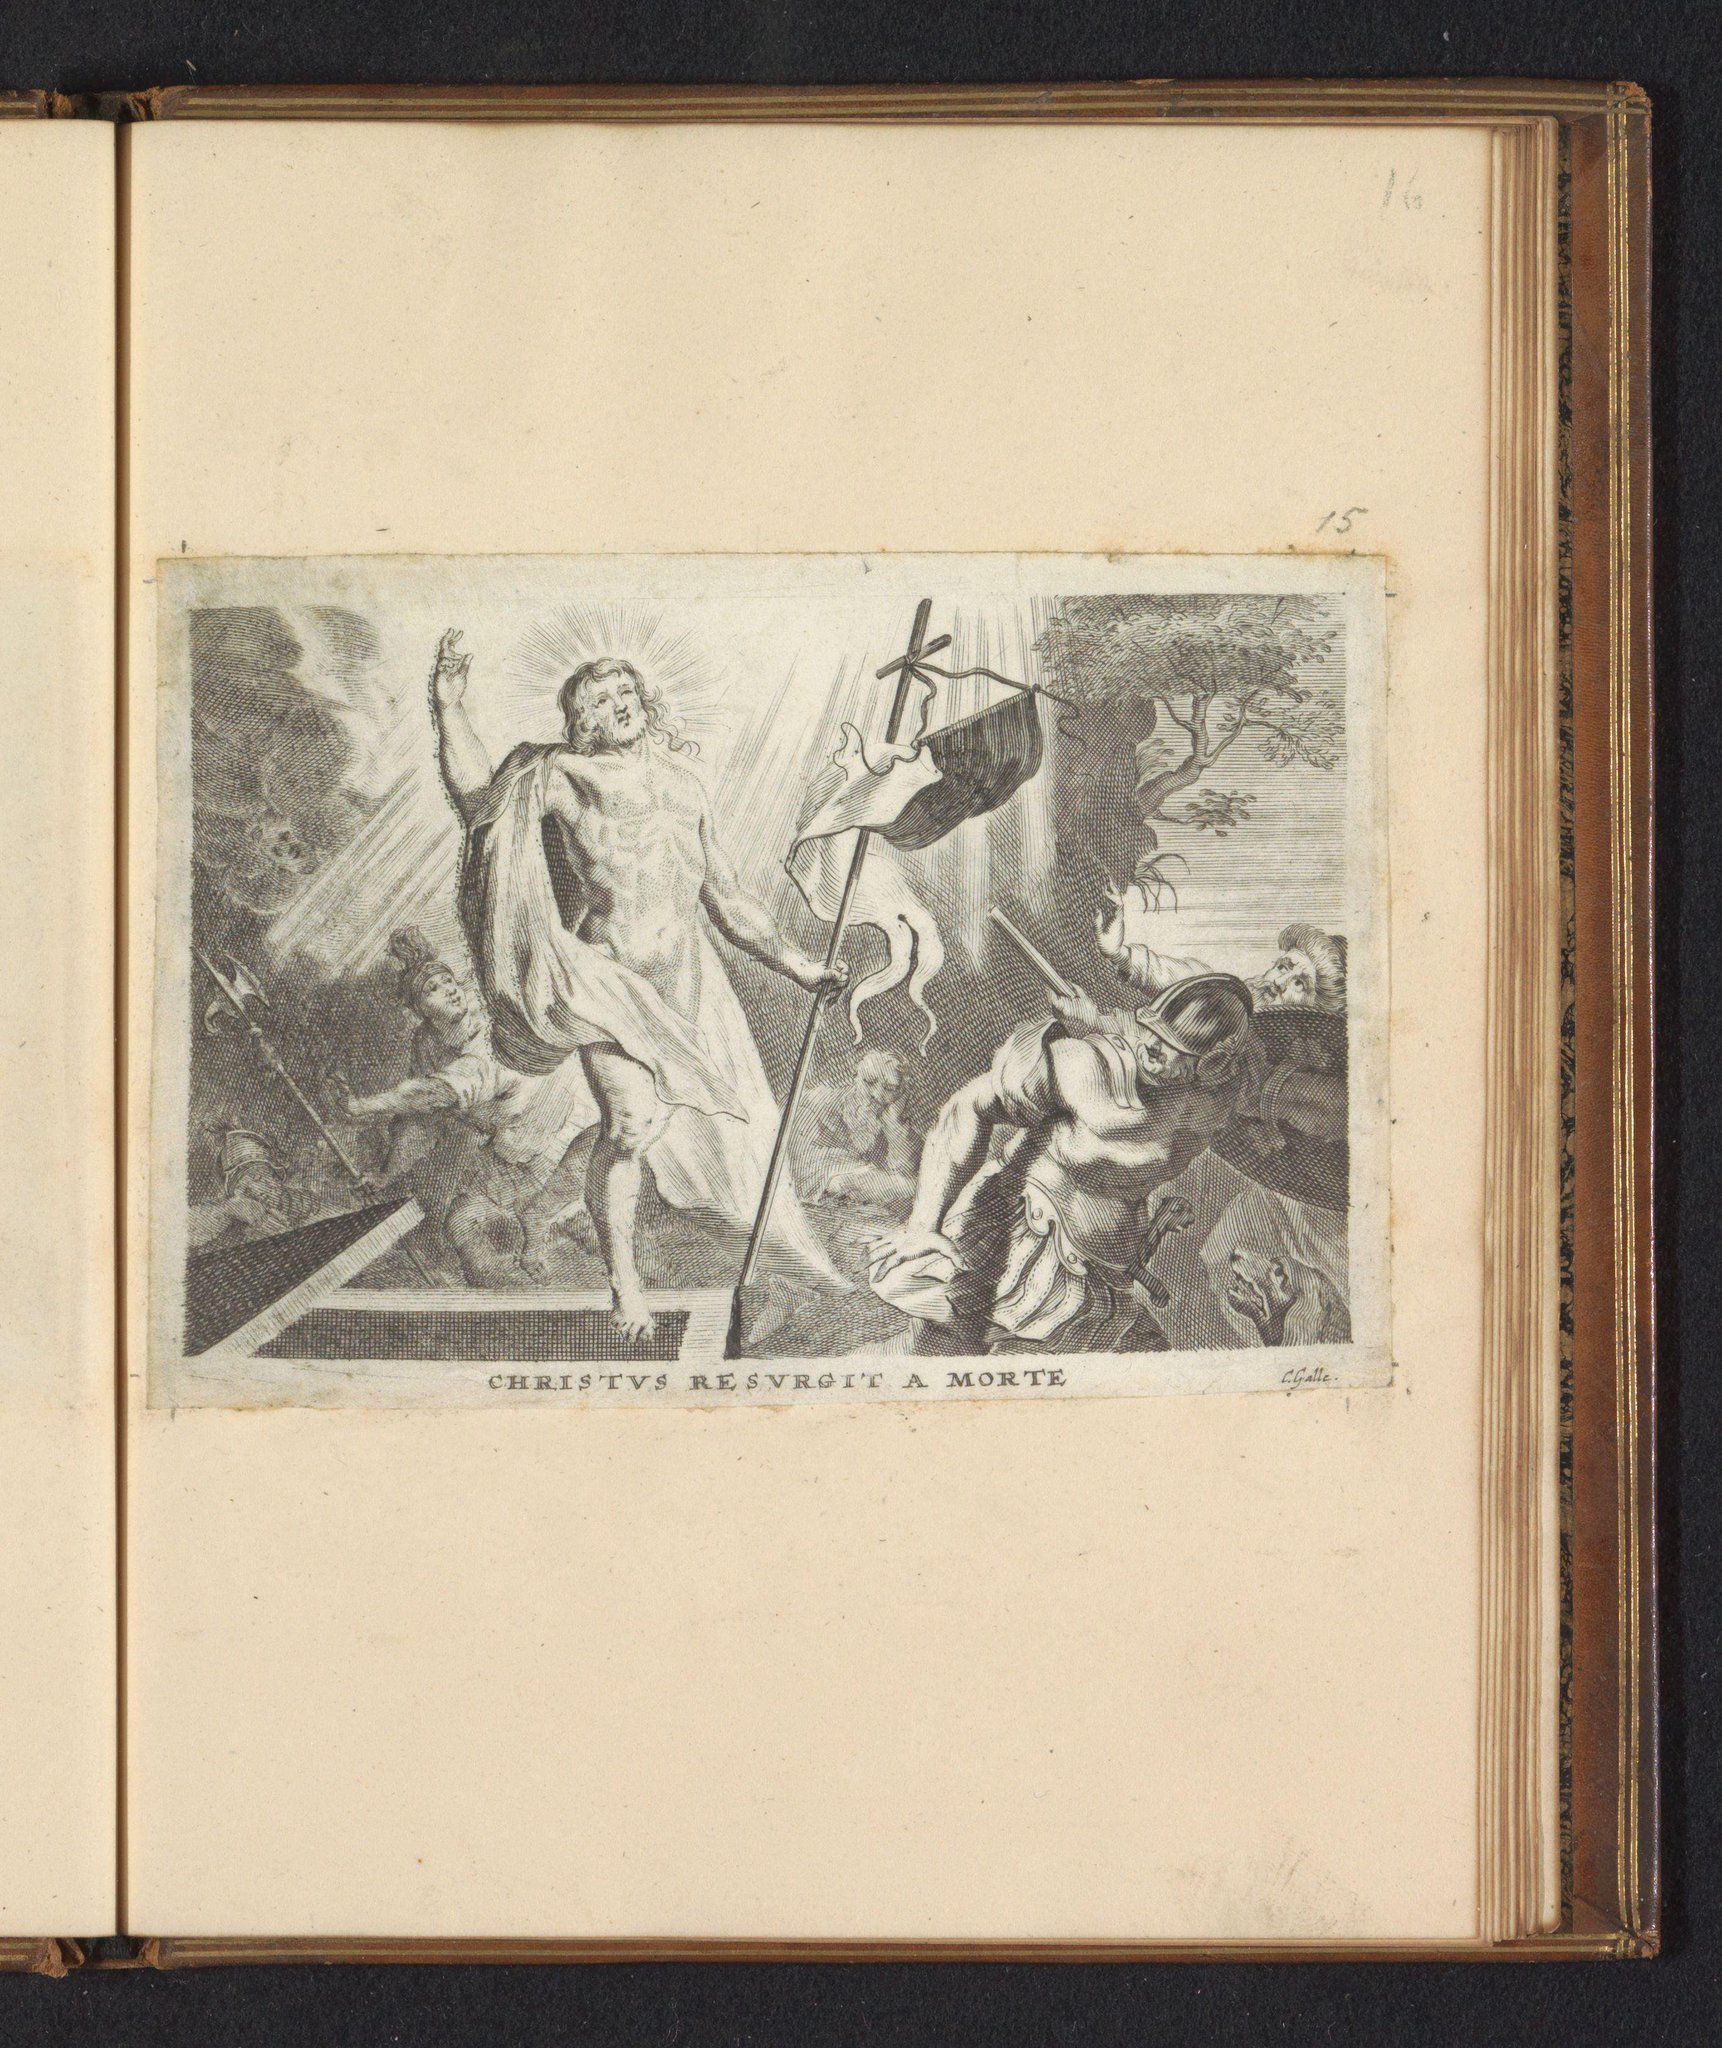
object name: print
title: Opstanding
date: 1640-1678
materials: paper, parchment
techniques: engraving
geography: antwerp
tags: christ, usually holding a banner, arises from the grave; often combined with sleeping and/or frightened soldiers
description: De opstanding van Christus. Eén prent uit prentalbum met negentien devotionele prenten op perkament.